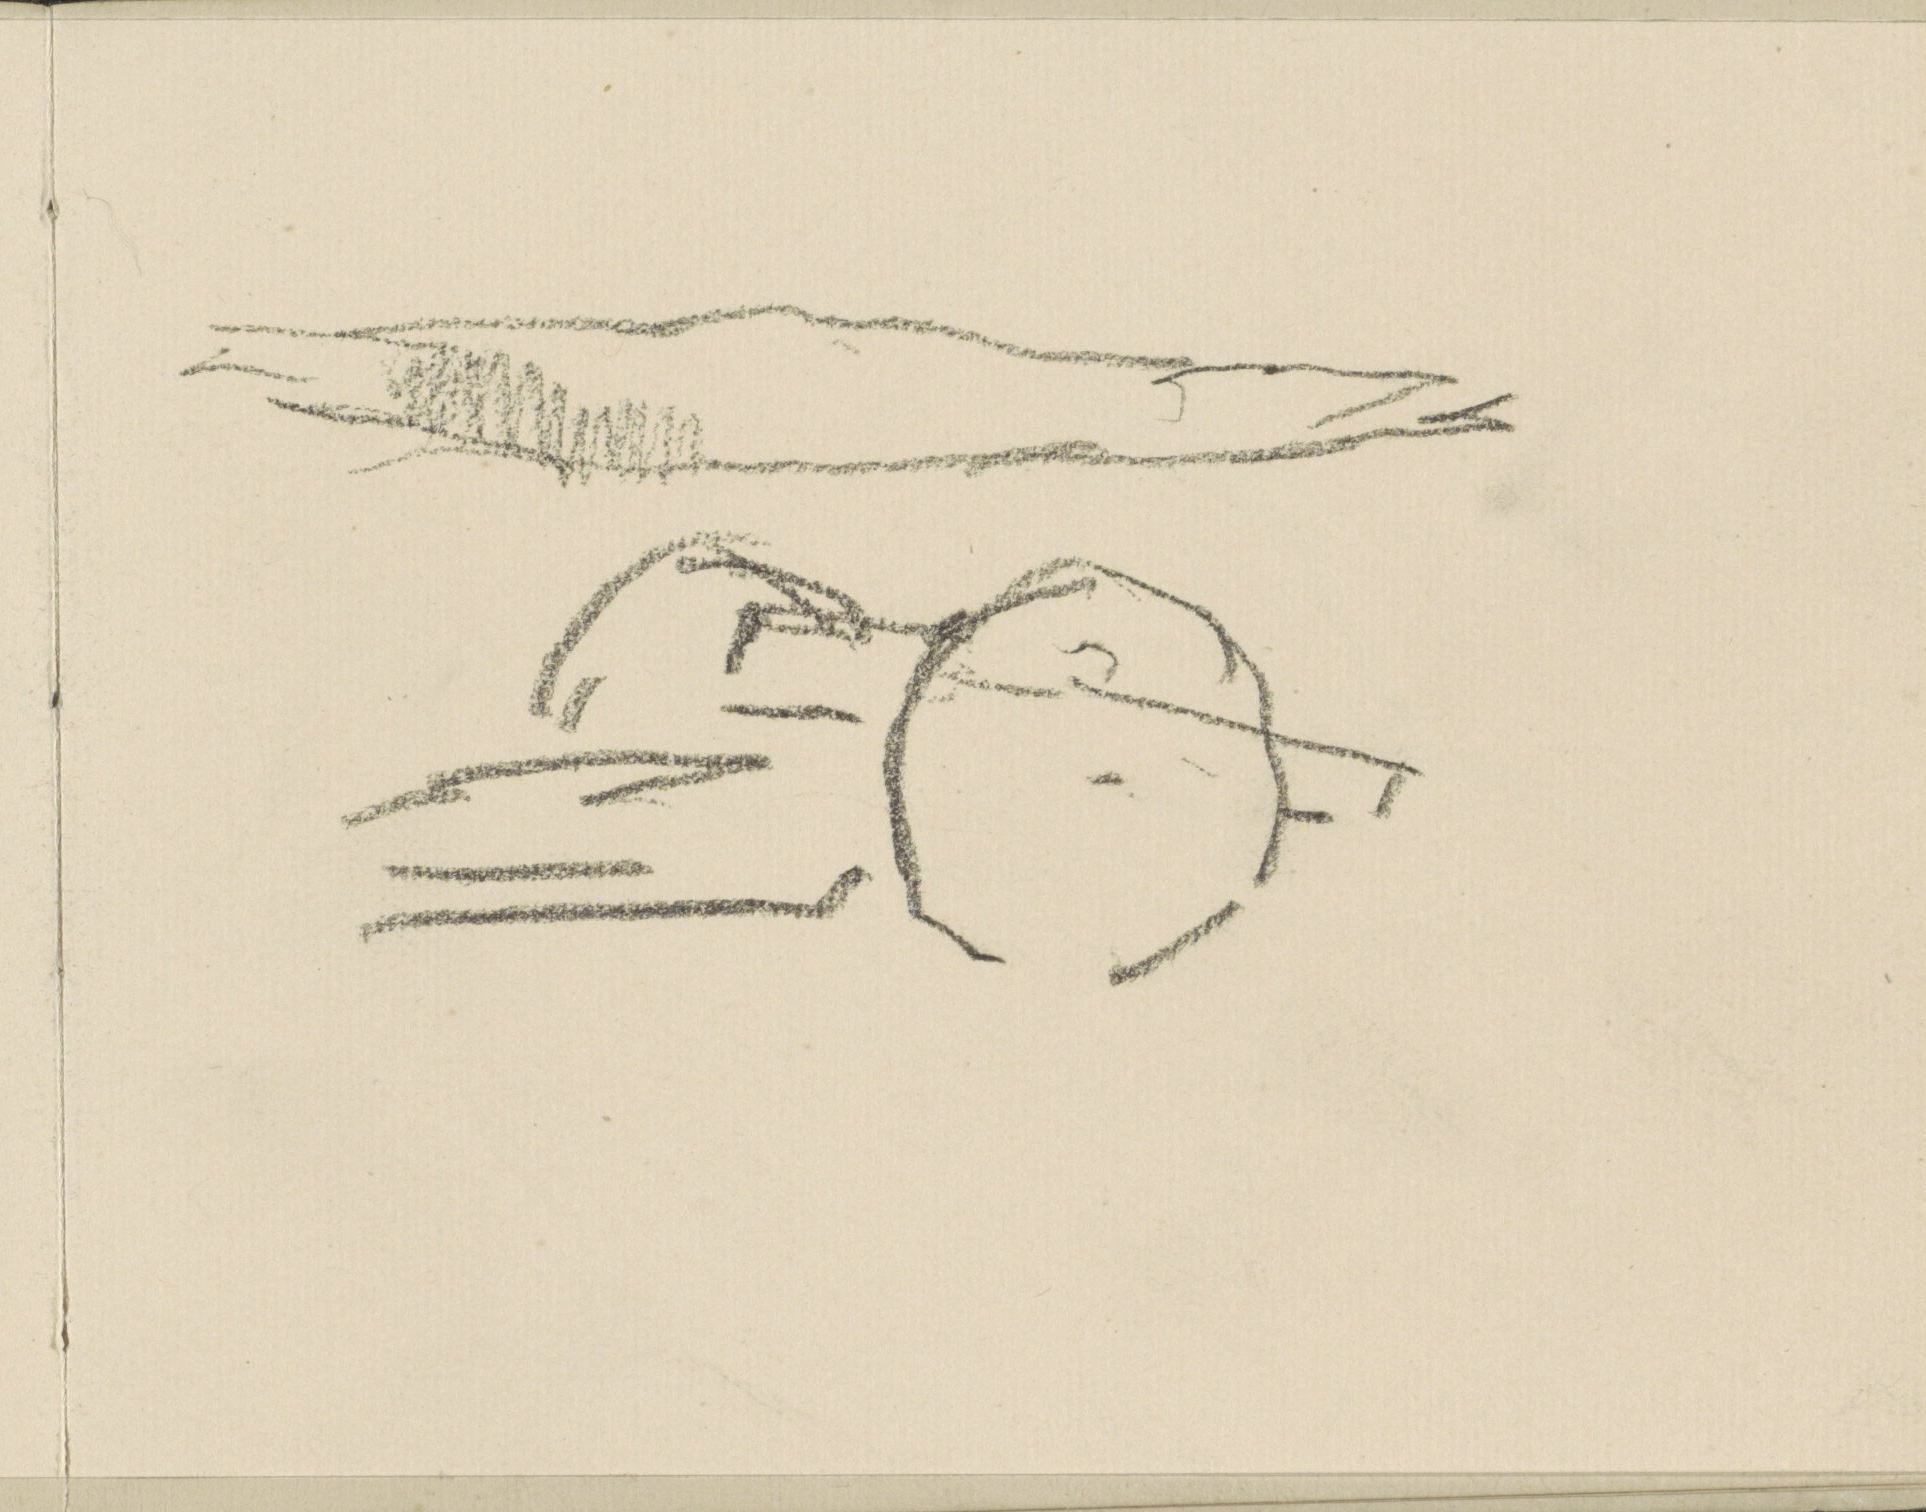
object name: sketchbook leaf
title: Kar of kanon in een landschap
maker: george hendrik breitner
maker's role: draughtsman, painter, print maker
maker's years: 1857-1923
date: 1885-1898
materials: chalk, paper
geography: ommen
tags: firearms: cannon, (farm) wagon, freight wagon, cart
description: Pagina 46 uit een schetsboek met 32 bladen.